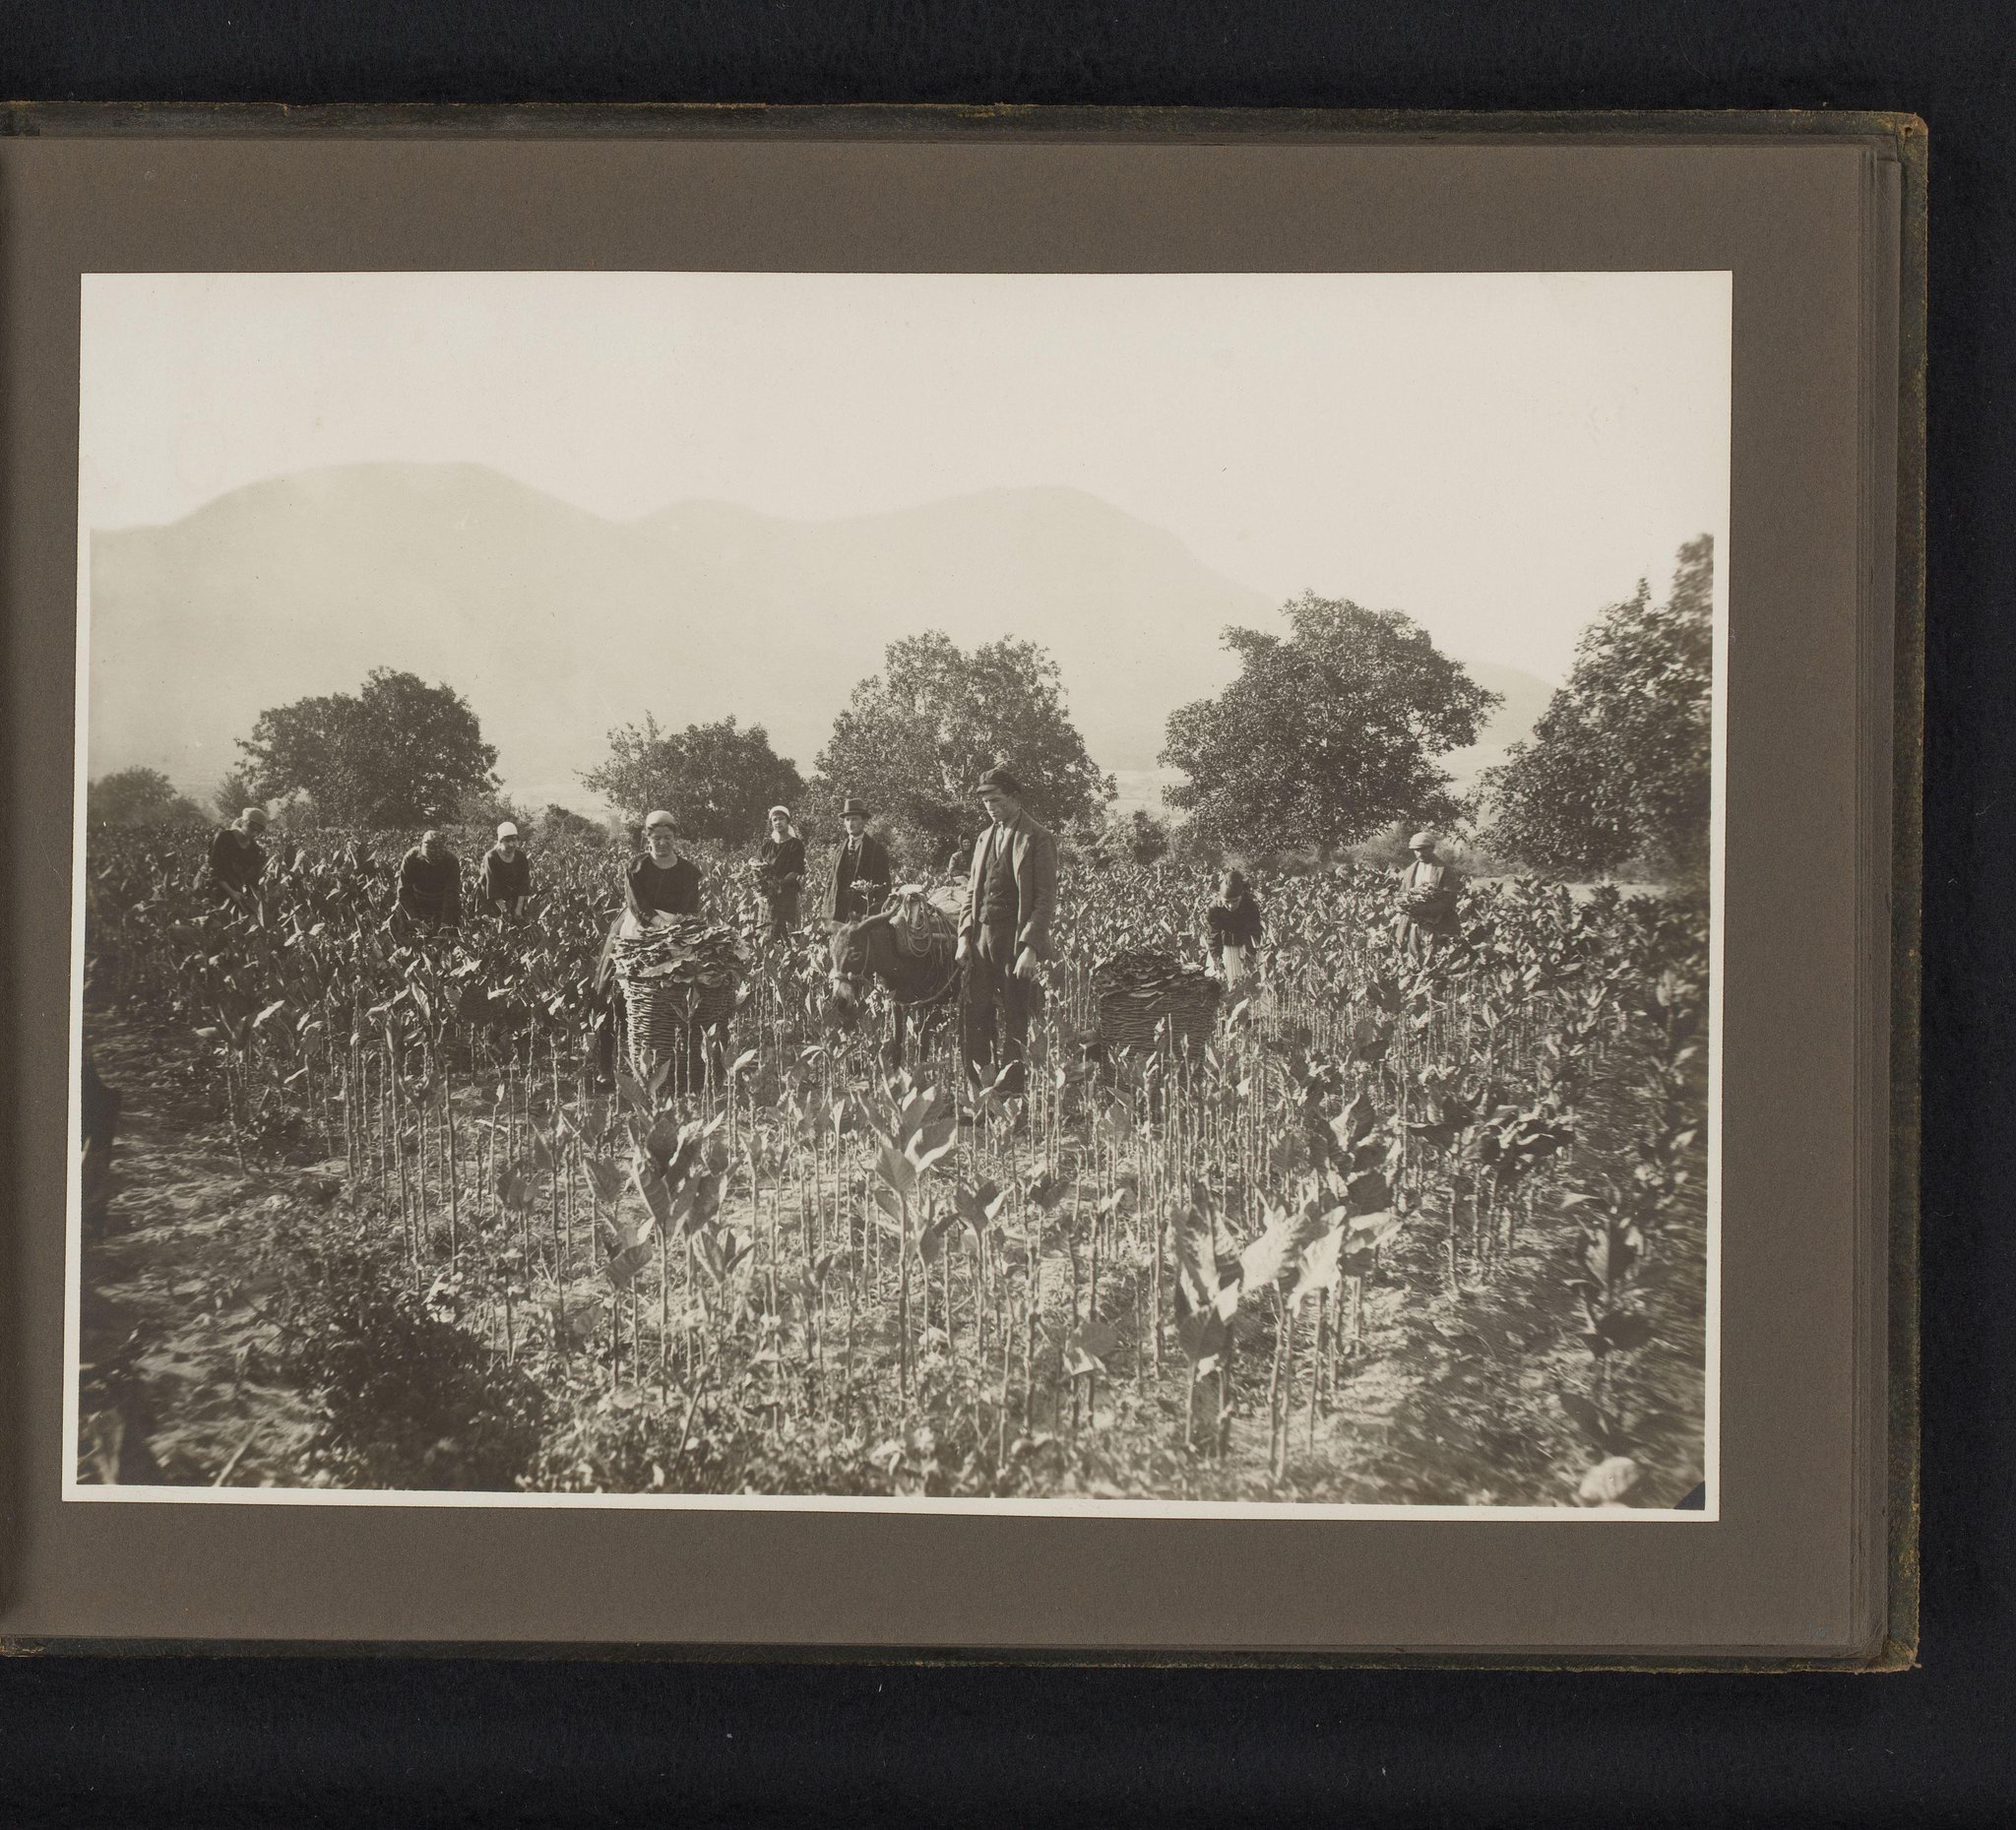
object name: album leaf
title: Oogsten van tabak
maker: Anonymous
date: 1925-1928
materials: cardboard, photographic support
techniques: gelatin silver print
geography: bulgaria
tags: eugen wachenheimer, harvest, (non-fruit) products of plants or trees: tobacco, folk costume, regional costume, tobacco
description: Een groep vrouwen en mannen op het veld bezig met het oogsten van tabaksbladeren, de vrouwen dragen witte mutsen. Onderdeel van het fotoalbum voor Eugen Wachenheimer bij zijn afscheid als directeur van het filiaal van de Deutsche Bank in Sofia, december 1928.